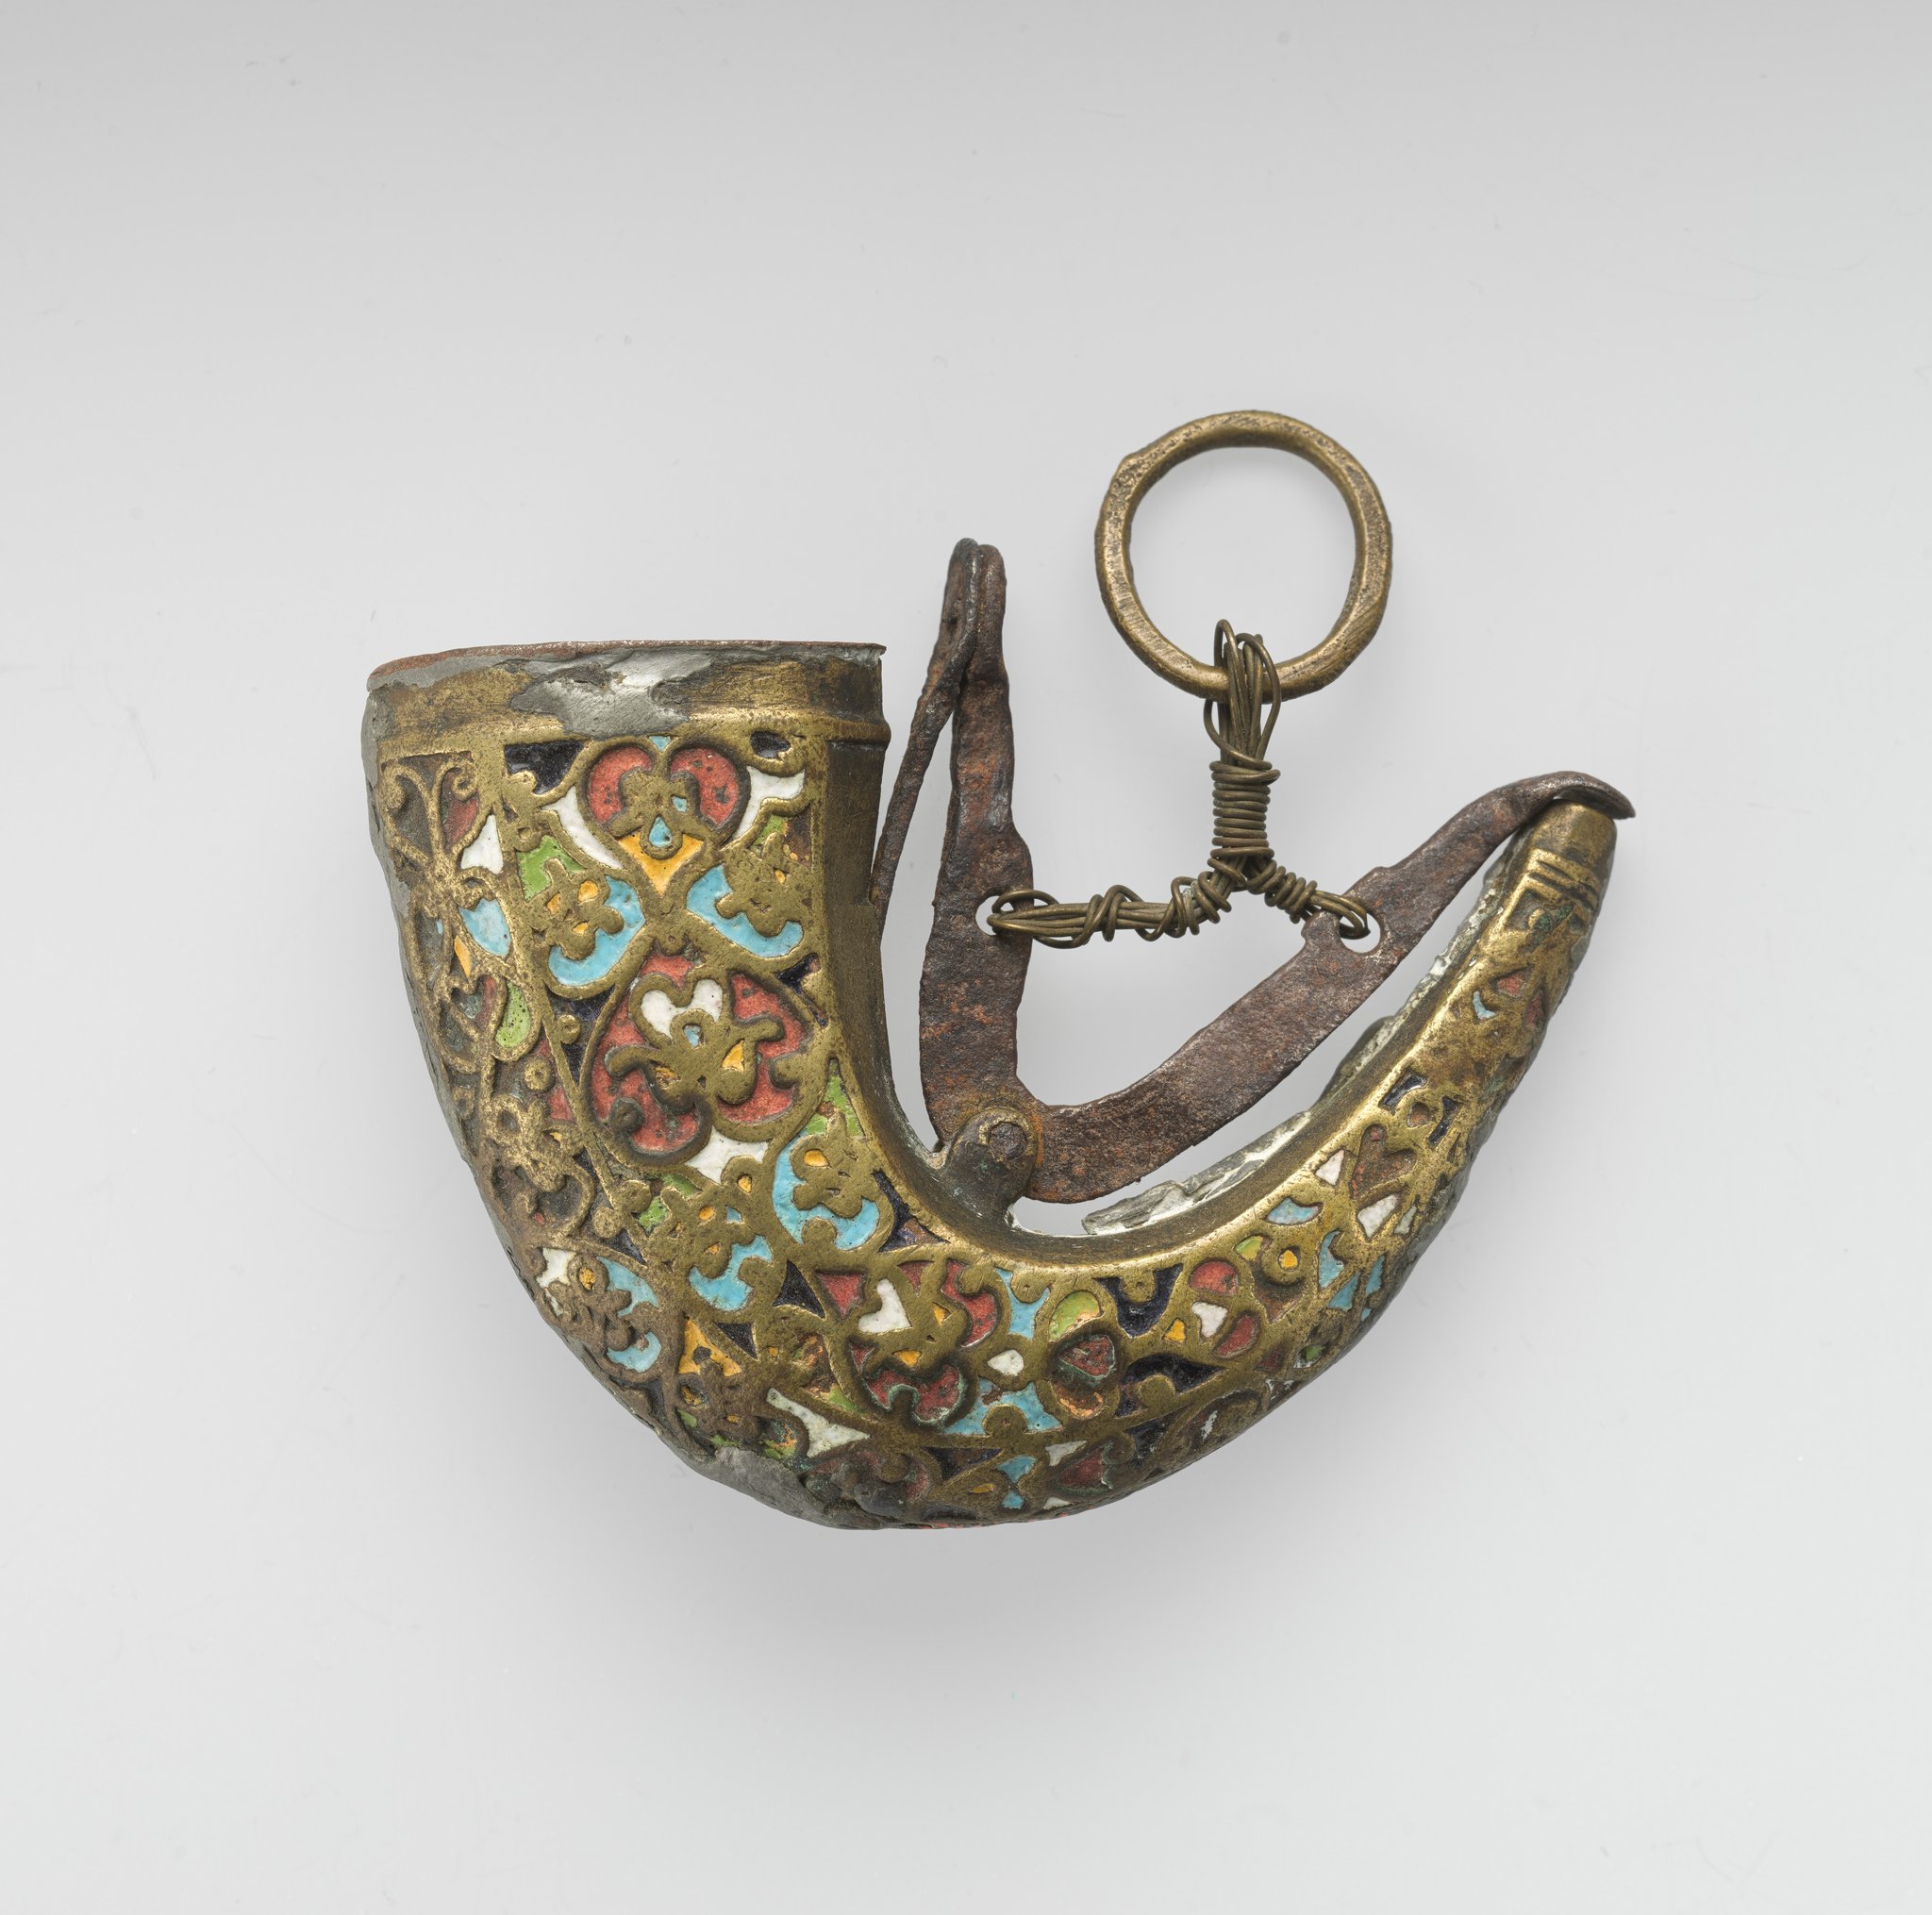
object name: hilt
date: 1701-1800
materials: brass, enamel, iron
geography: india